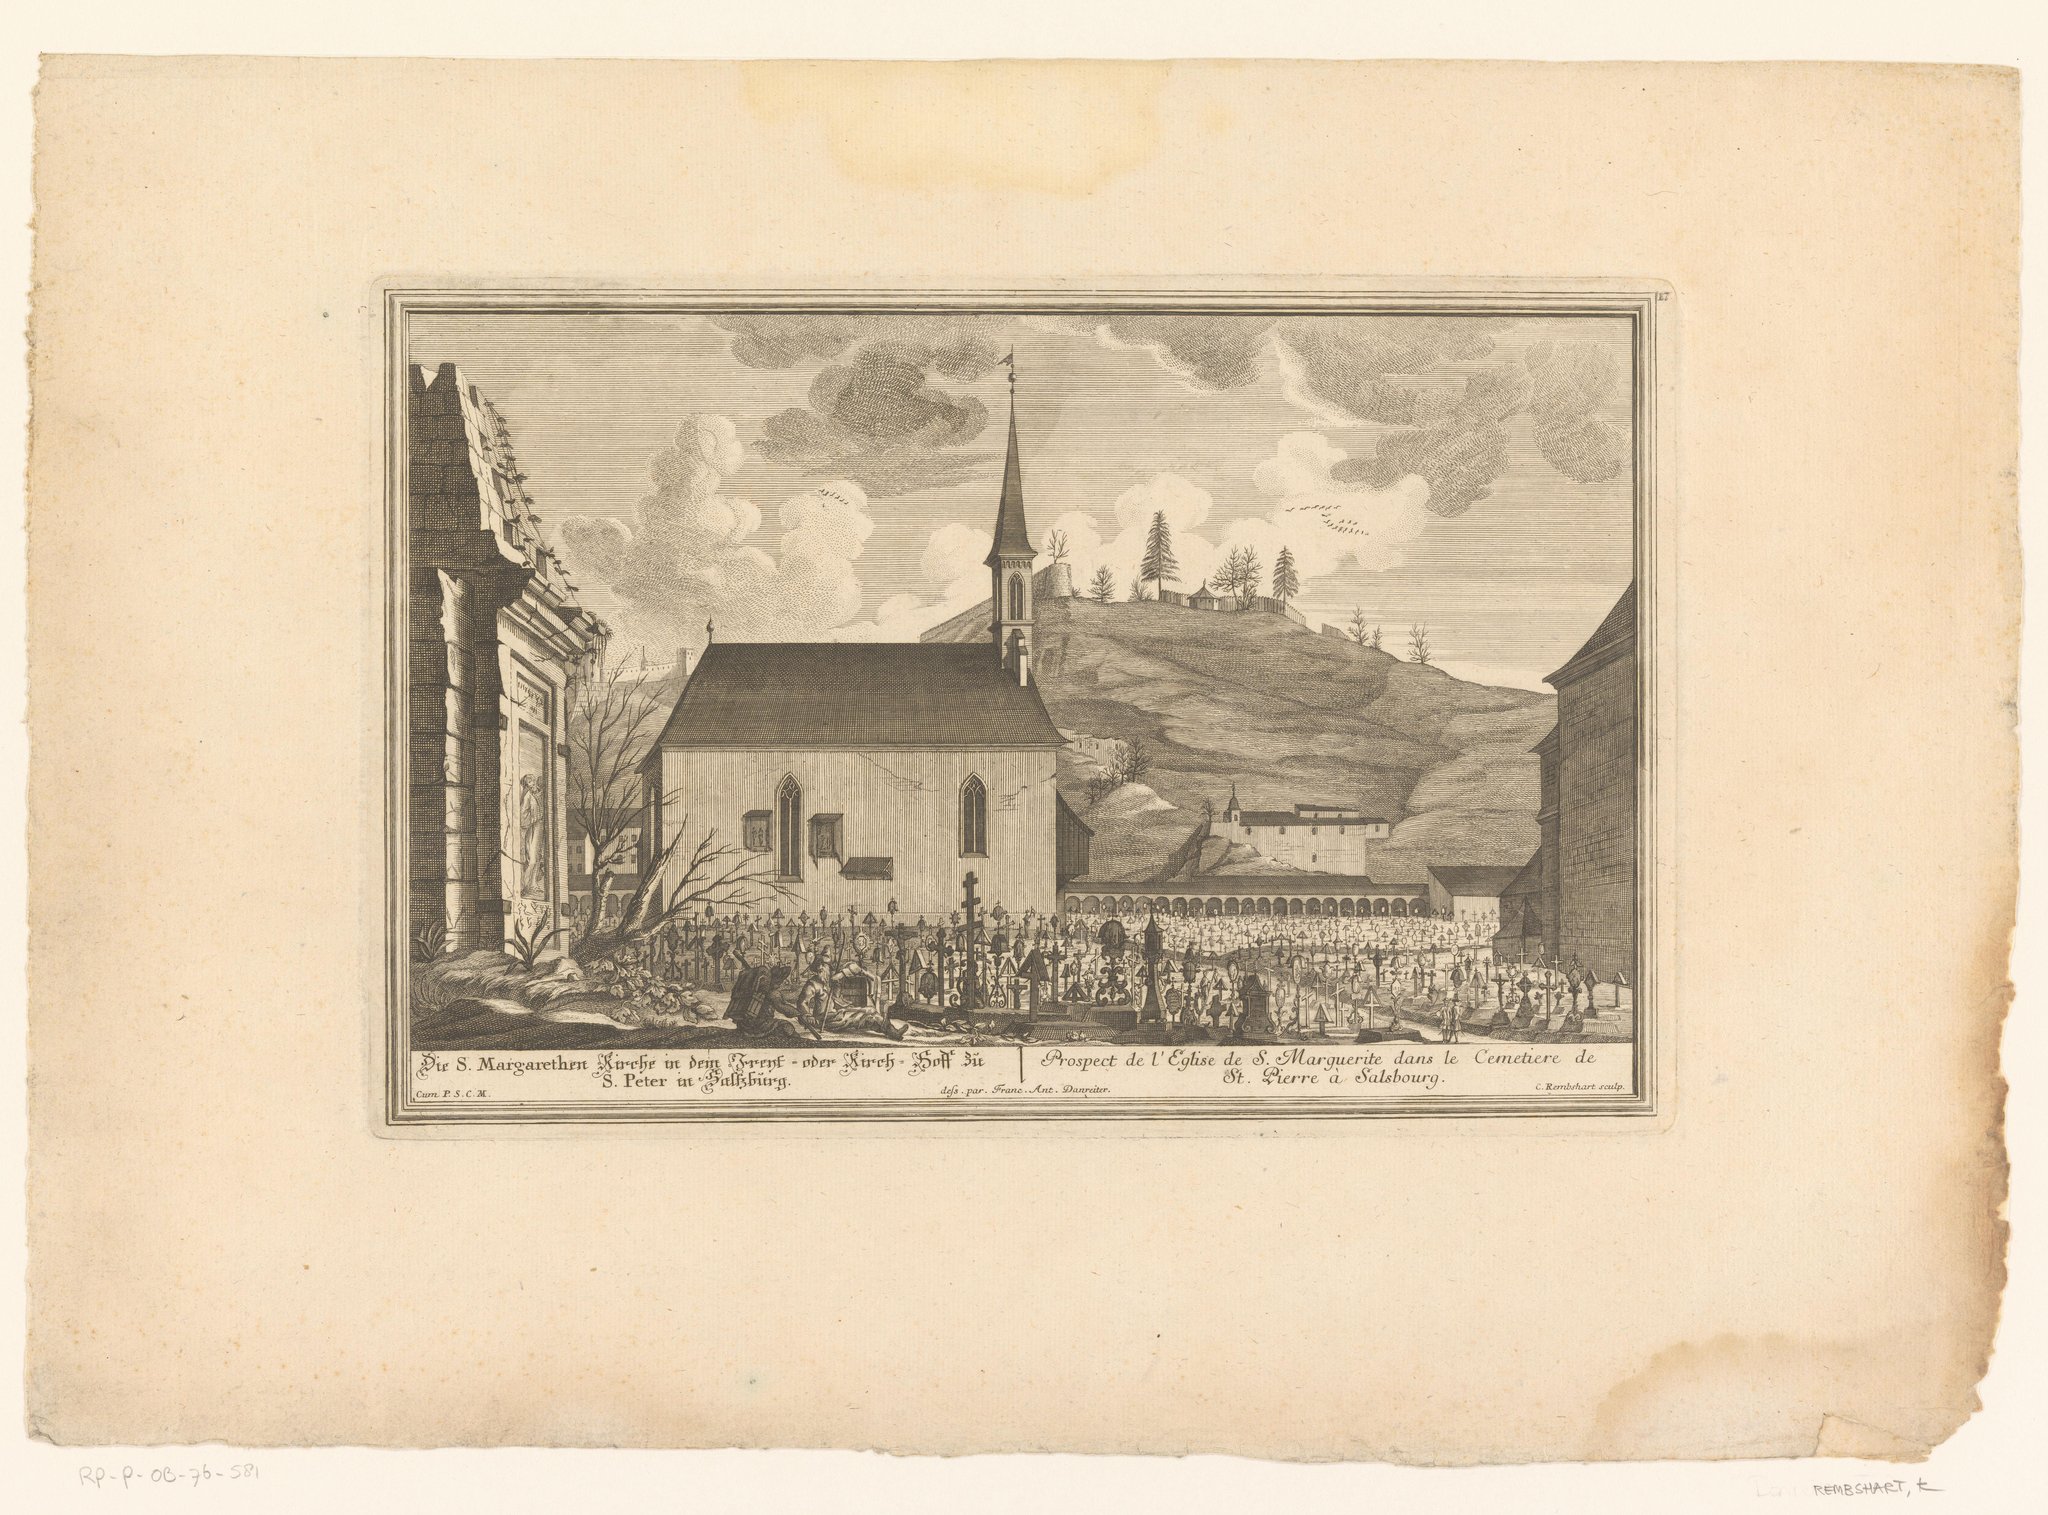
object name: print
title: Die Saltz-burgische Kirchen-Prospect (...)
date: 1730-1740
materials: paper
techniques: engraving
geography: augsburg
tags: churchyard, cemetery, parts of church interior: chapel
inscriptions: collector's mark: Lugt 2228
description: Noordzijde van de Margarethenkapel op de begraafplaats van Sint Peterskloosters in Salzburg.